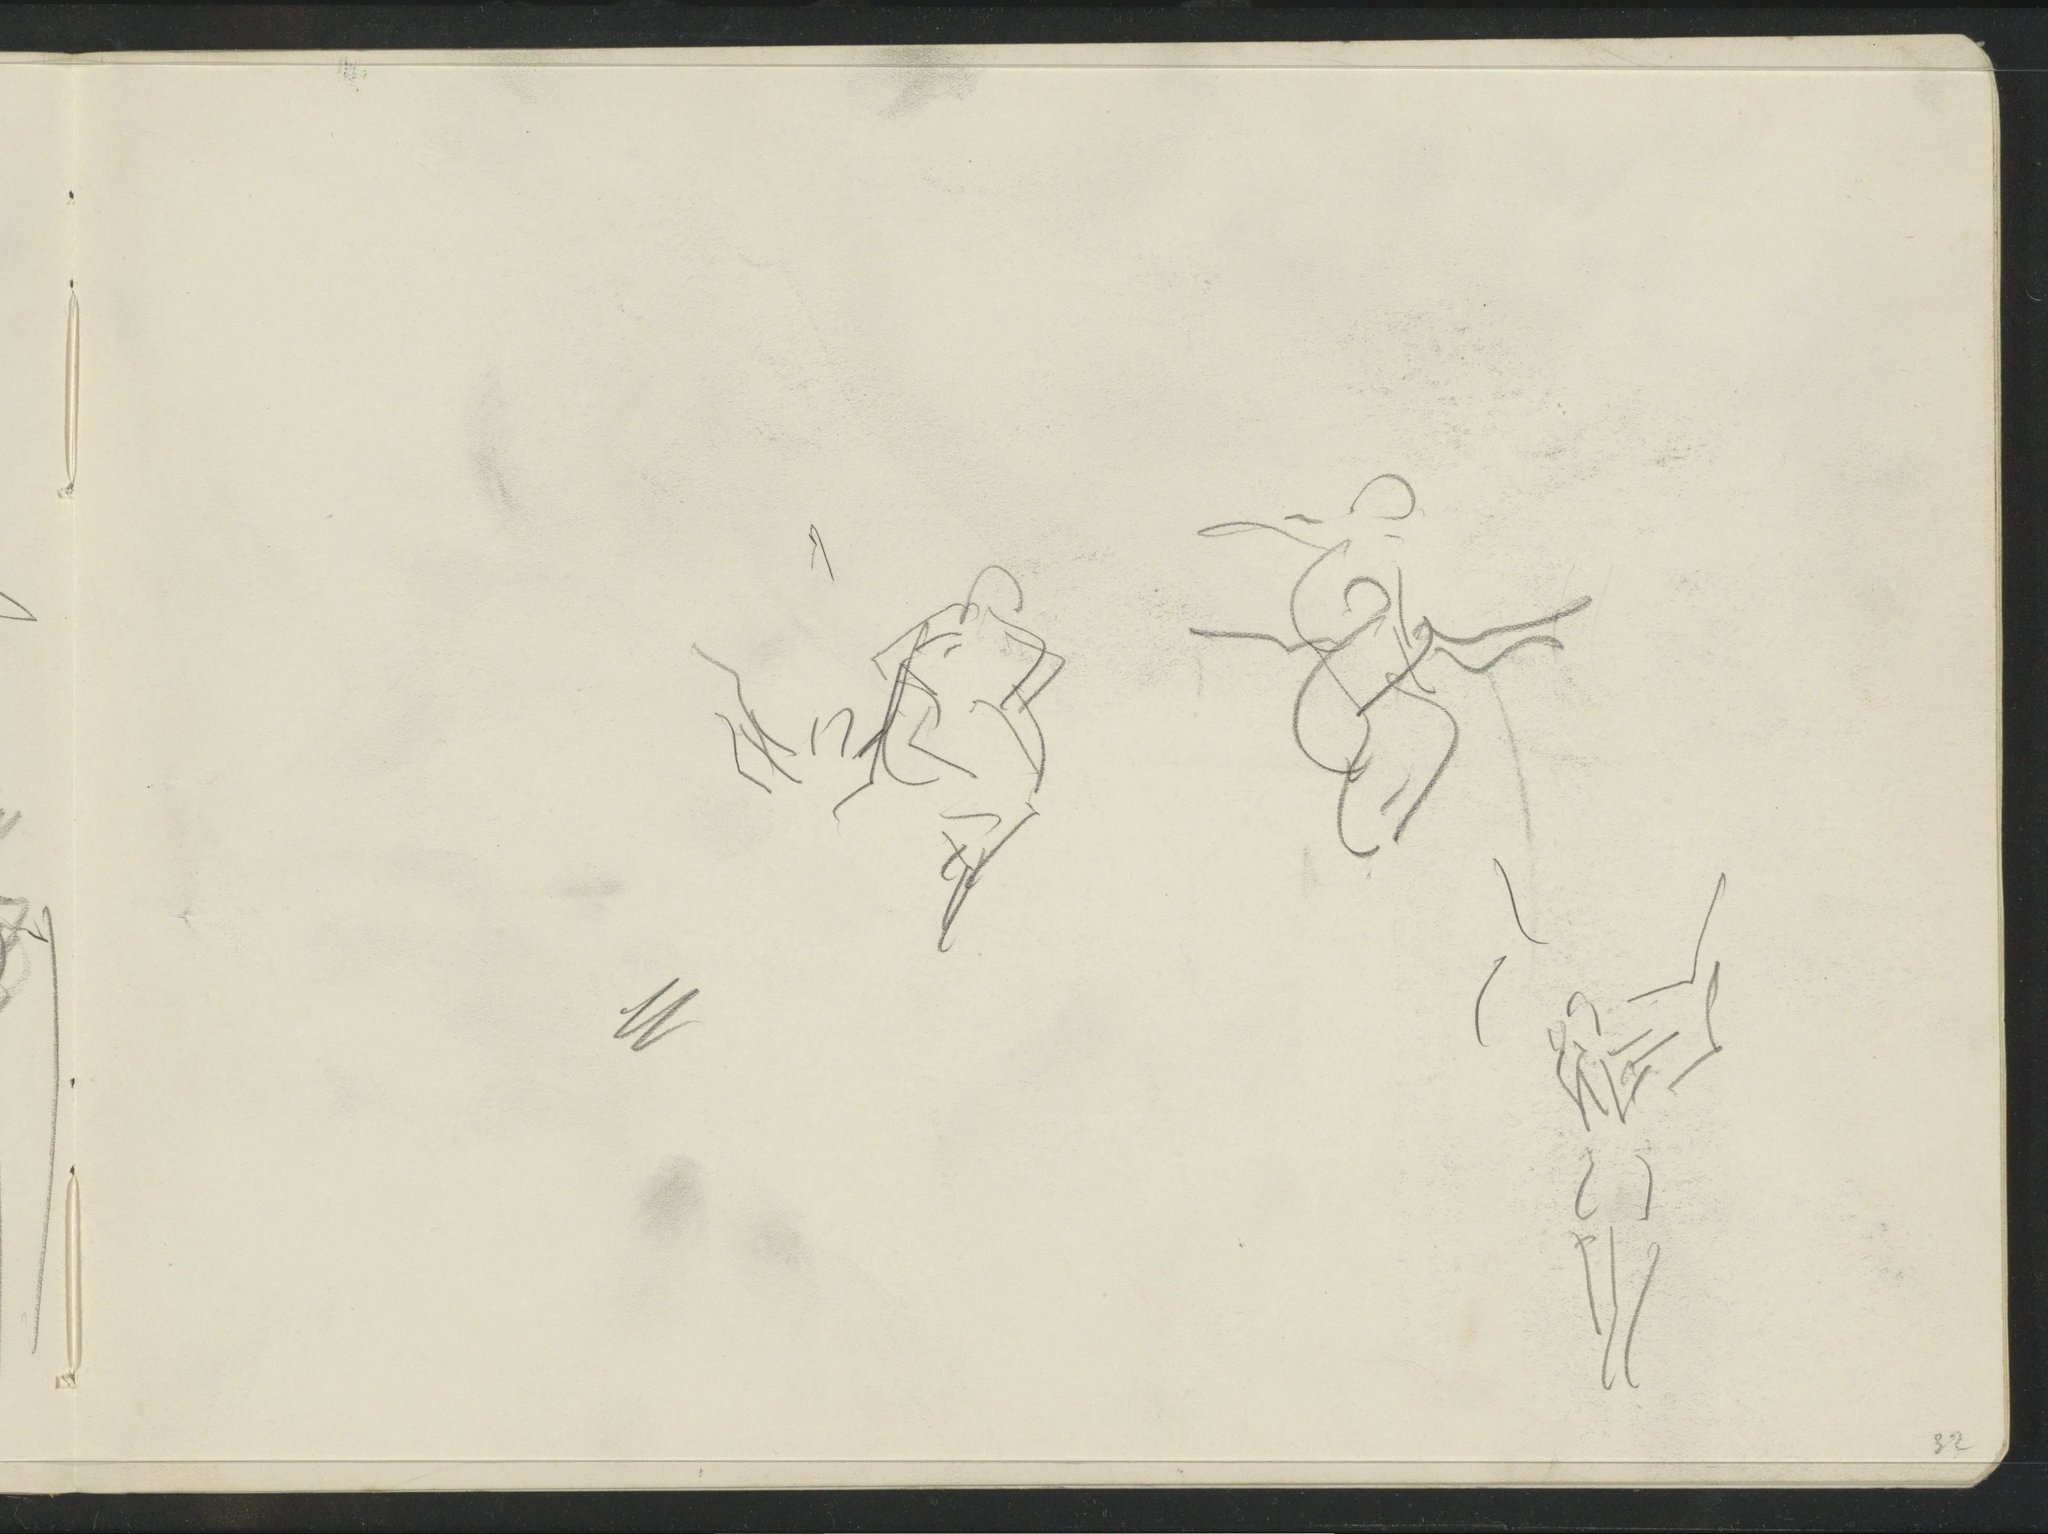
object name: sketchbook leaf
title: Figuurstudies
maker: isaac israels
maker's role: draughtsman, painter, print maker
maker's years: 1865-1934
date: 1915-1934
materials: paper, pencil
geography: the hague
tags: postures of the human figure, female dancer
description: Mogelijk dansers. Blad 32 recto uit schetsboek XVIII met 35 bladen.